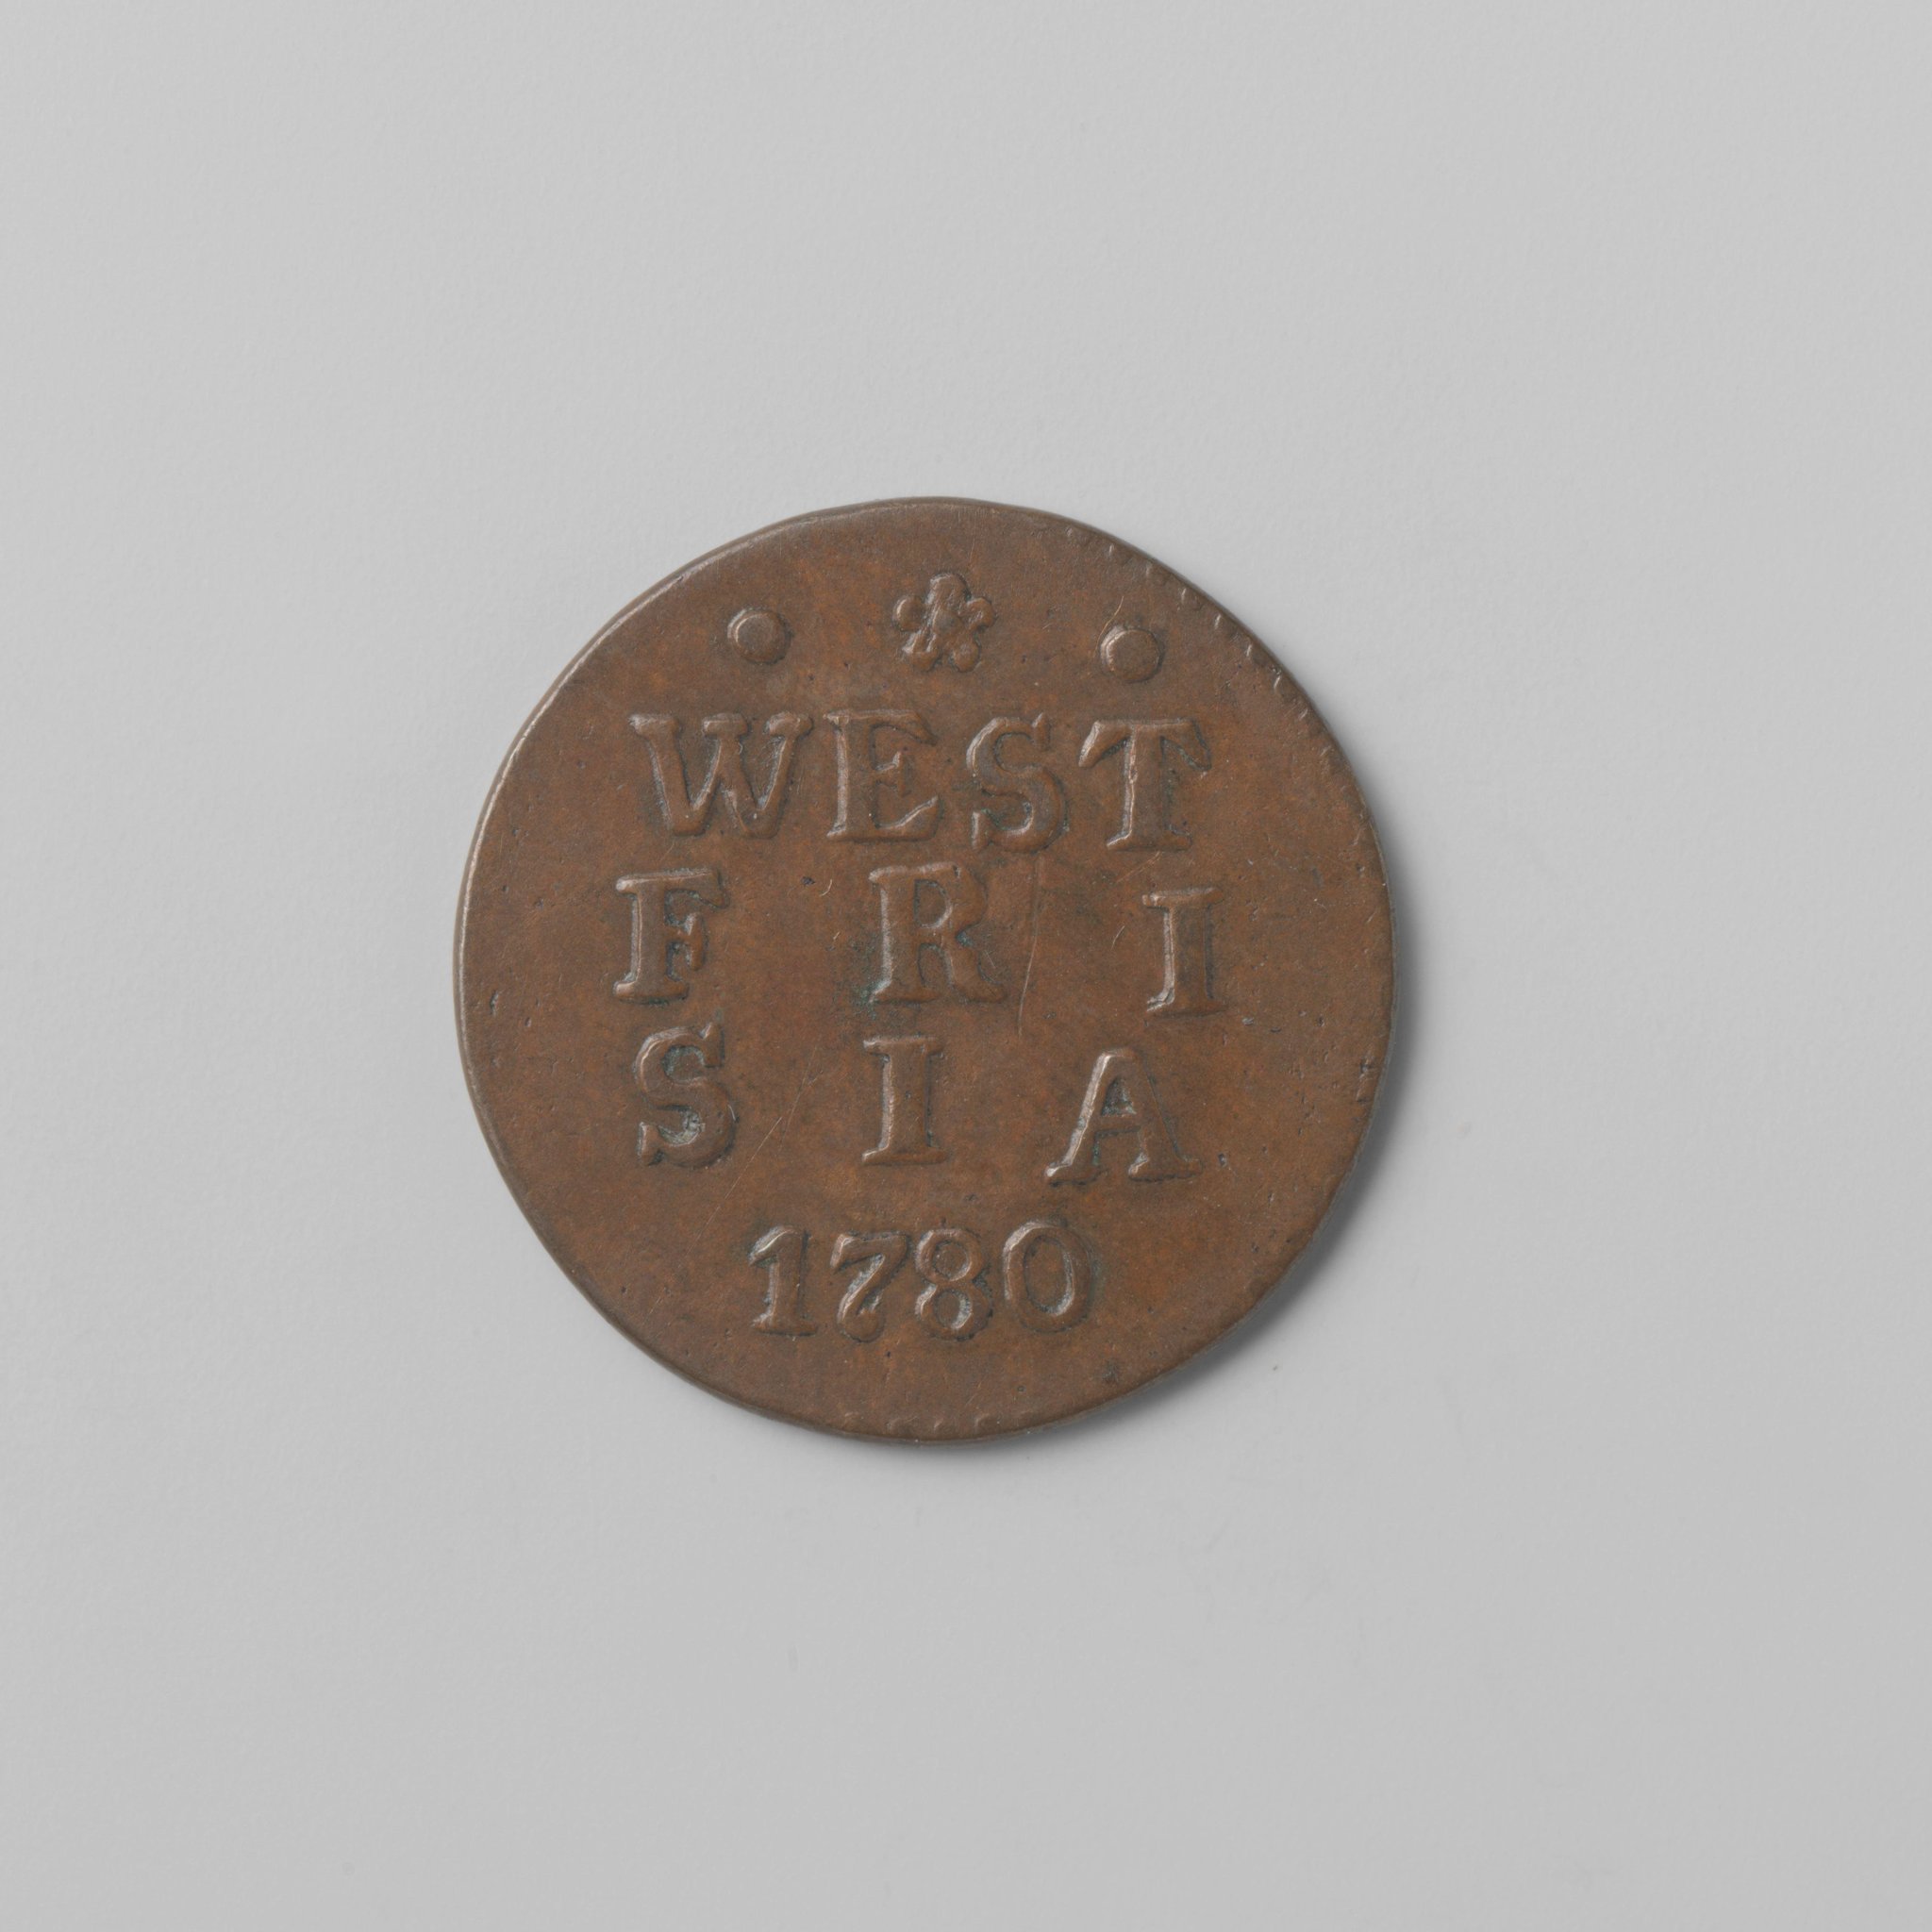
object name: coin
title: West-Friesland, duit, 1780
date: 1780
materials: copper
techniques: striking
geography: west frisia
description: Koperen munt. Voorzijde: gekroond wapenschild van West-Friesland met lauwertakken. Keerzijde: opschrift in drie regels. Daarboven muntteken rozet tussen twee punten. Daaronder jaartal.